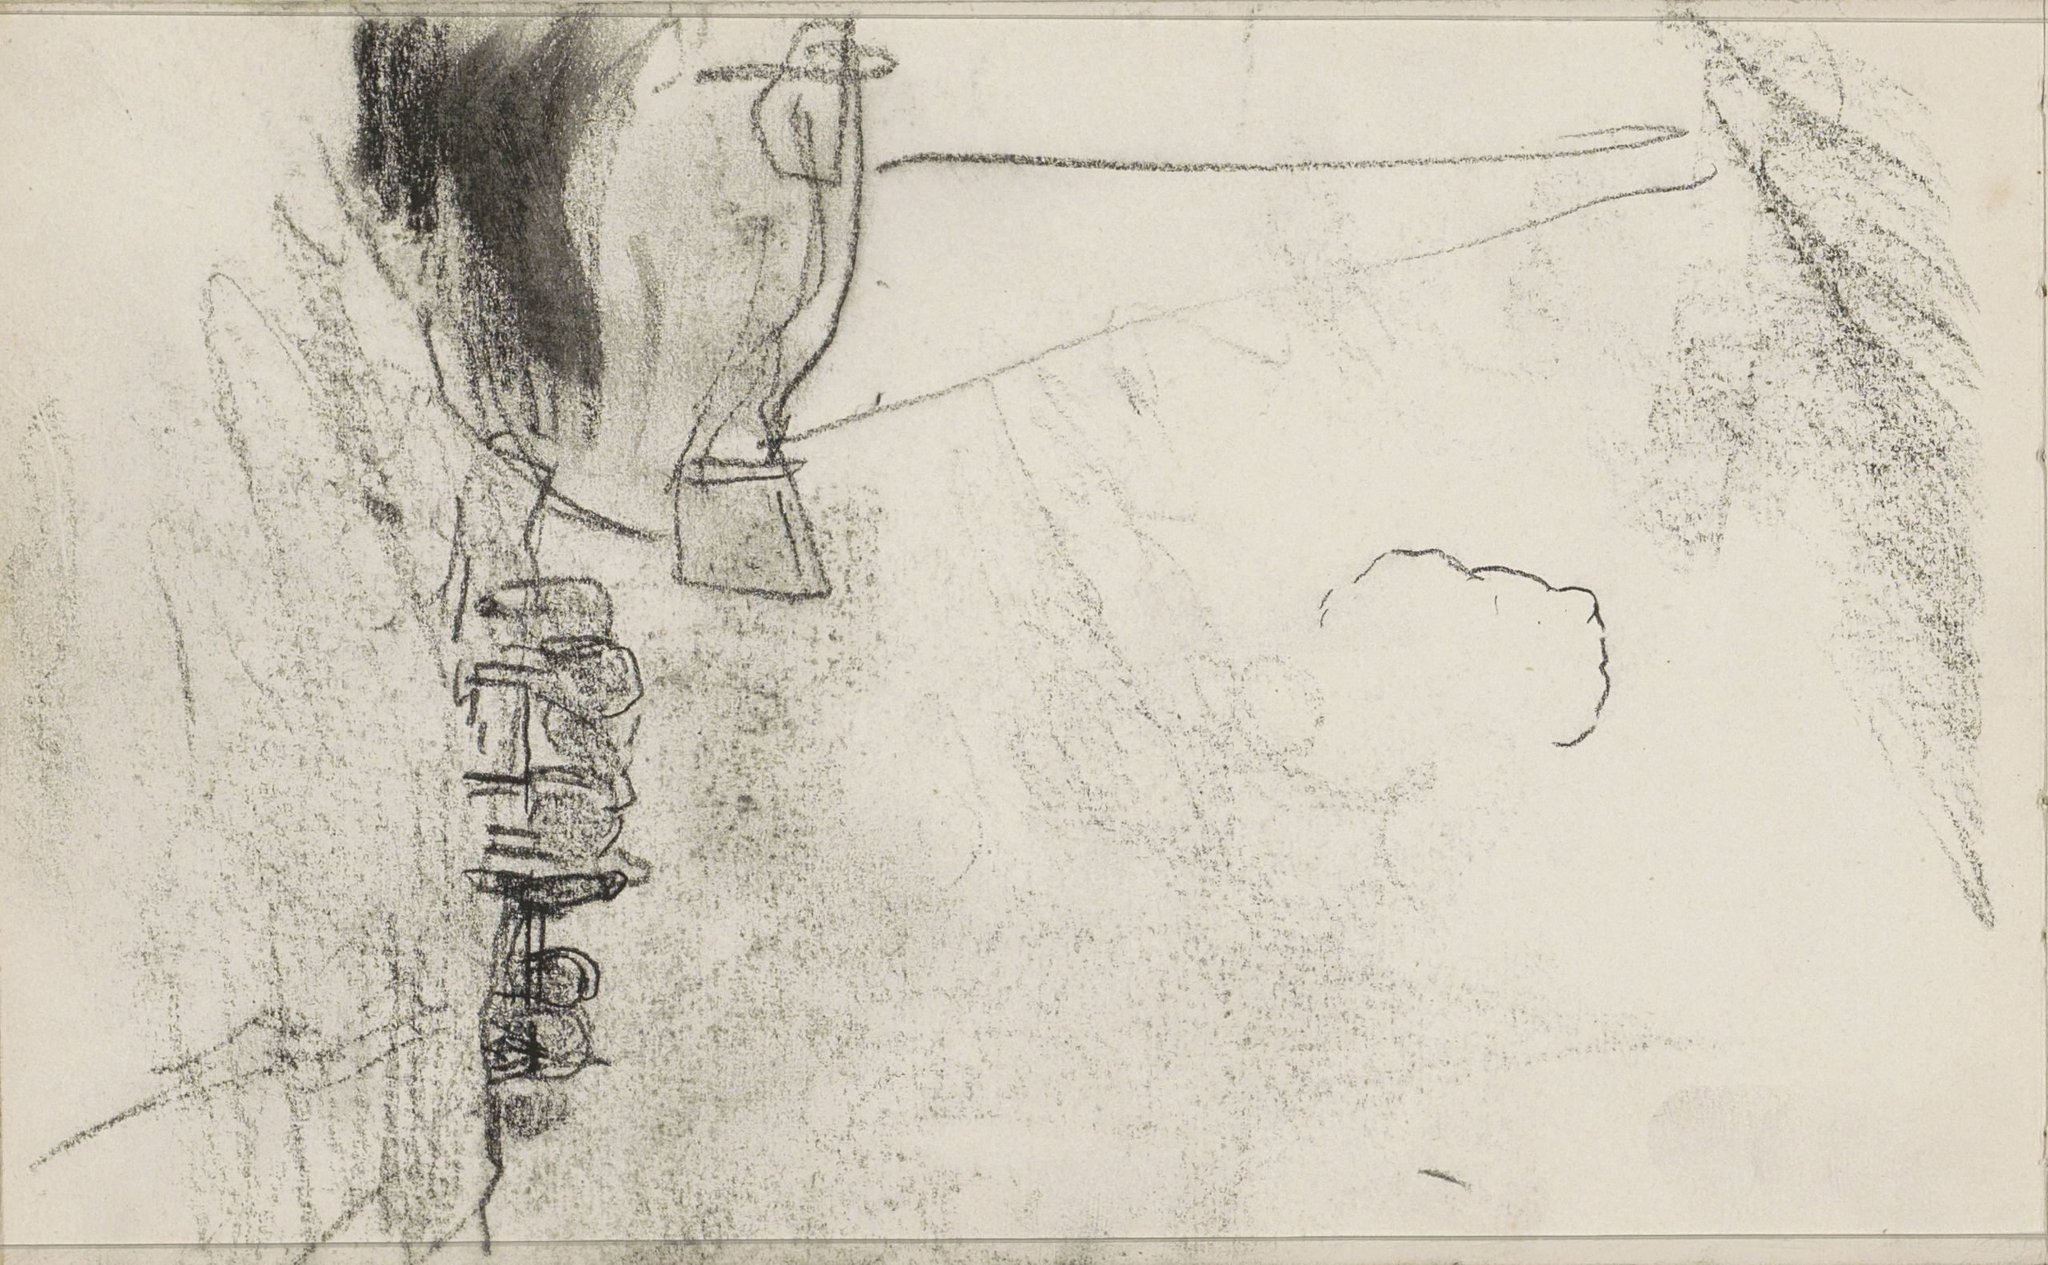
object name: sketchbook leaf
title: Paarden bij een bomschuit op het strand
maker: anton mauve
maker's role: draughtsman, painter, print maker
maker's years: 1838-1888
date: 1848-1888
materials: chalk, paper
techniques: brush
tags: sailing-ship, sailing-boat, horse, beach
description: Blad 37 verso uit een schetsboek met 41 bladen.